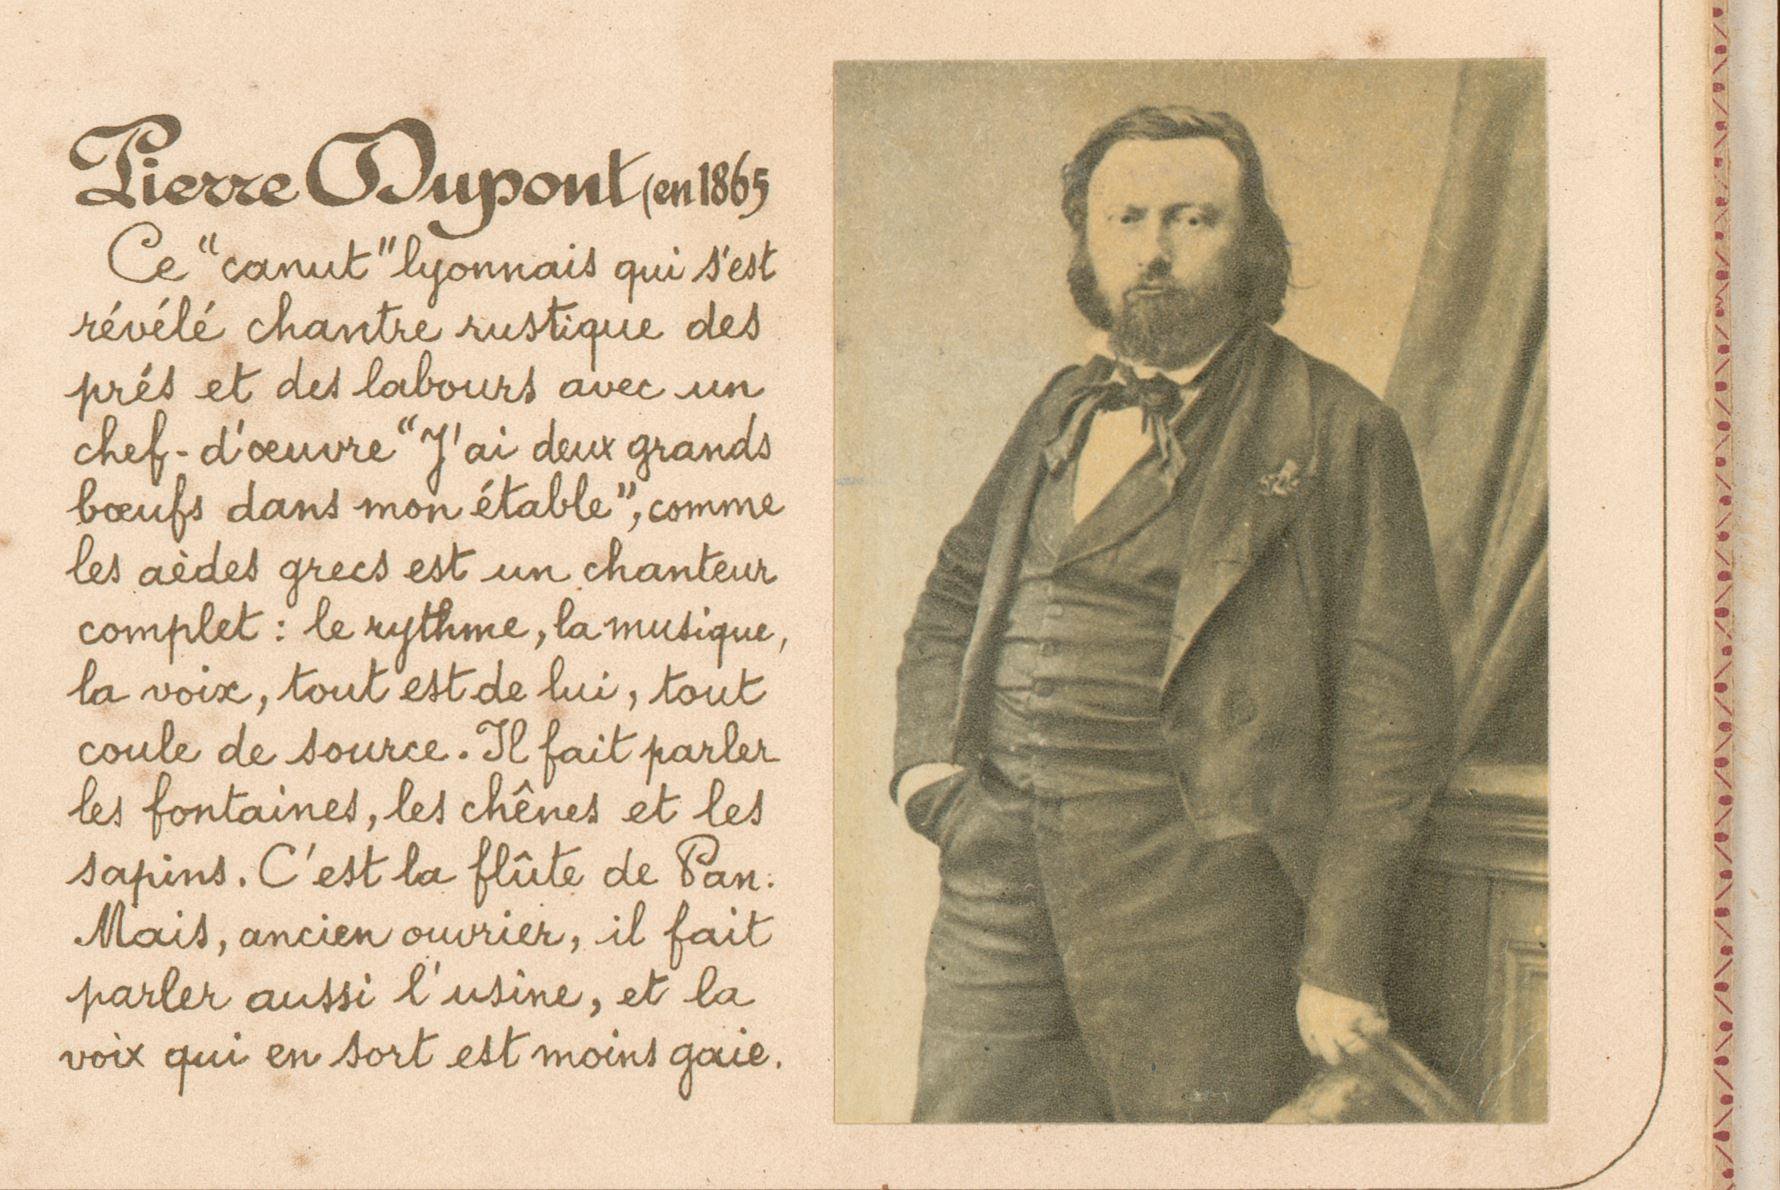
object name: photograph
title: Portret van Pierre Dupont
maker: Anonymous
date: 1865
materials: paper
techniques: rotogravure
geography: france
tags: lyon, male singer, france